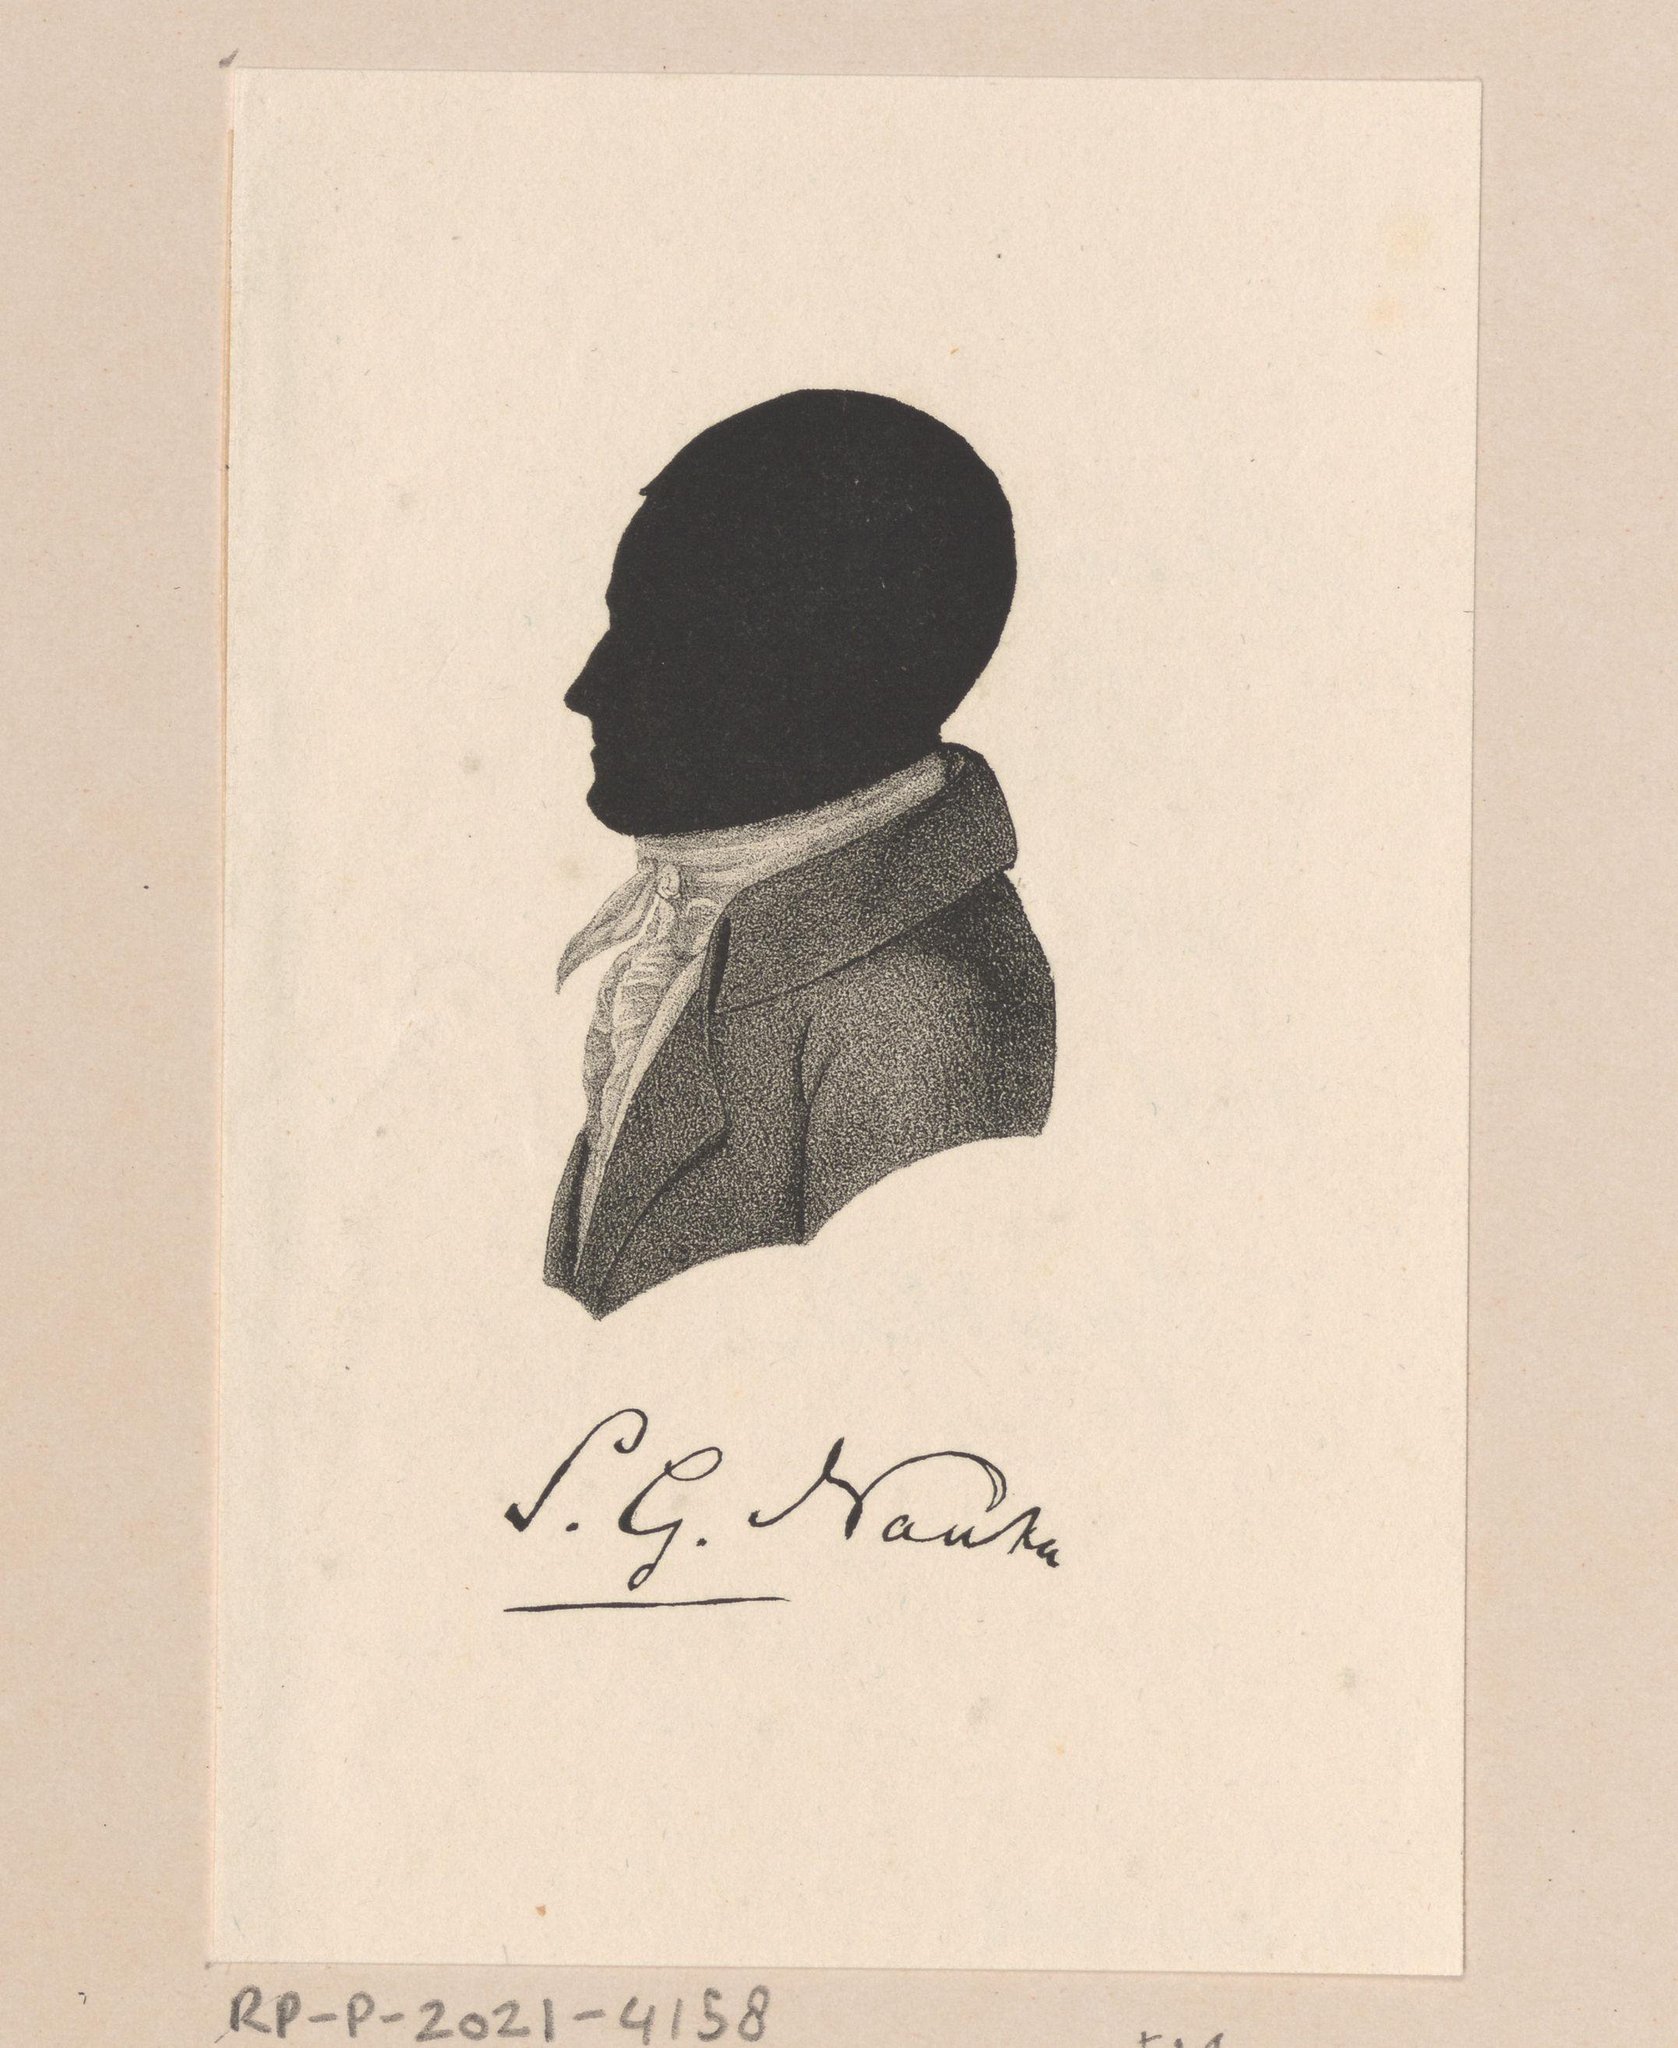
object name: print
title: Silhouetportret van Sicco Godefridus Nauta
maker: Anonymous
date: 1800-1820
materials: paper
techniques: aquatint, etching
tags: historical persons